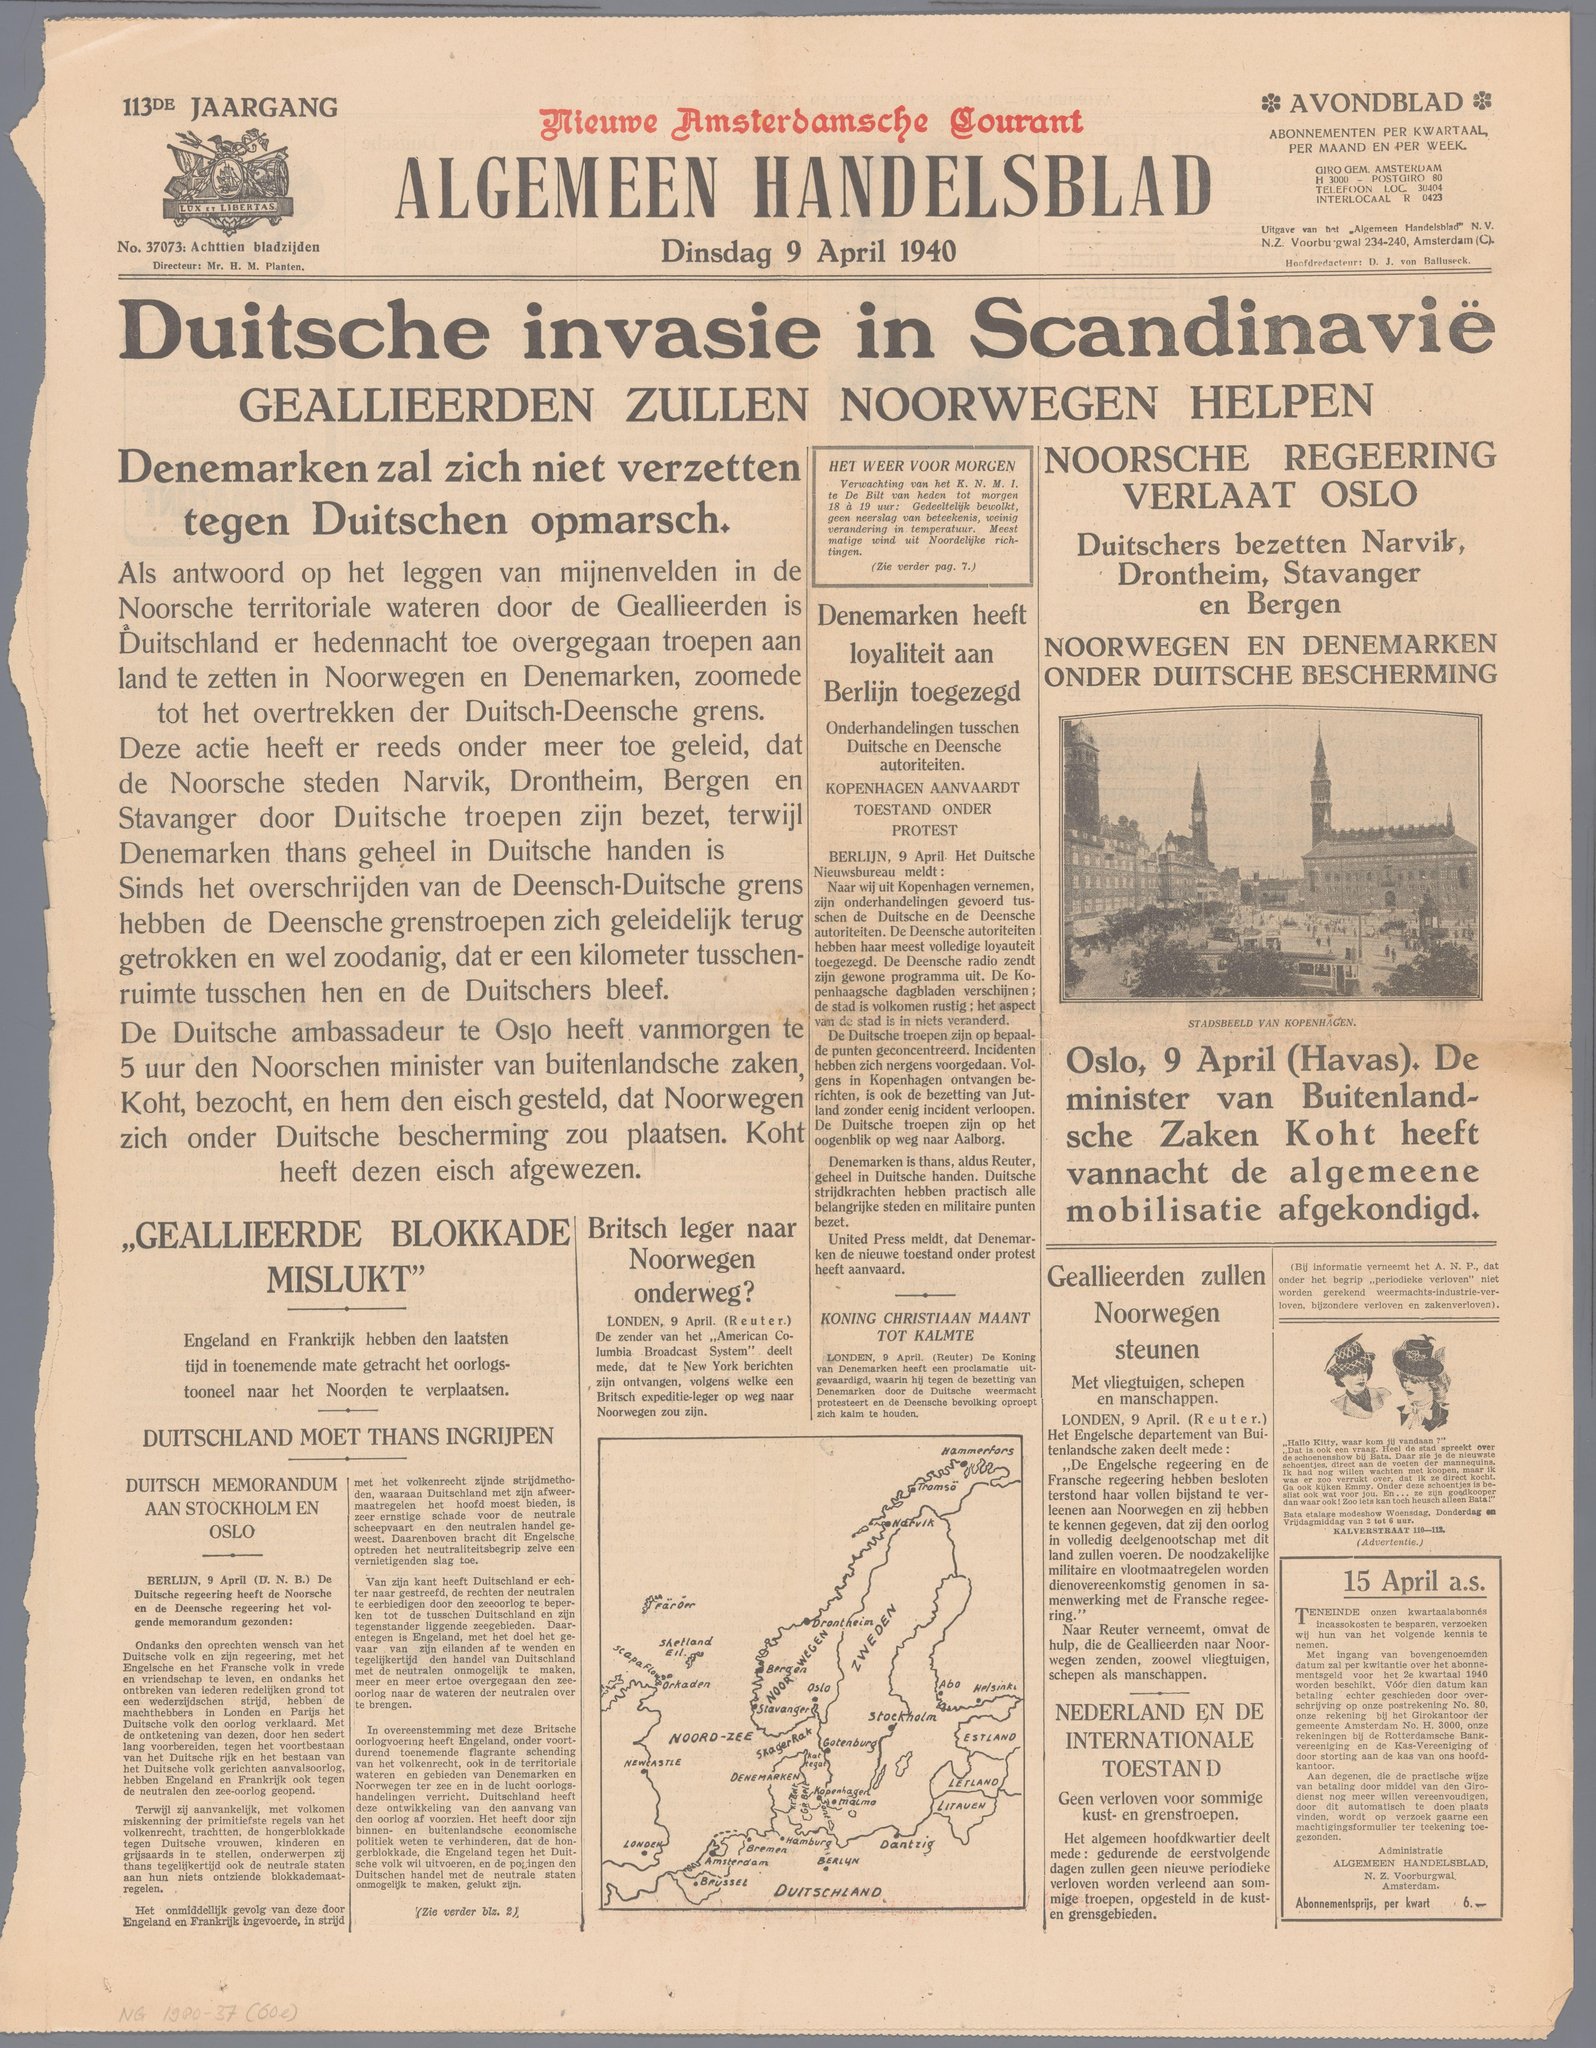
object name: newspaper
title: Algemeen Handelsblad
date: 1940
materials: paper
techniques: printing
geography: amsterdam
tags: scandinavië, tweede wereldoorlog, duitse invasie in scandinavië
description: Krant over de duitse invasie in Scandinavië, 4 pp. (van 18) van nr. 37073 van de 113e jaargang van de Algemeen Handelsblad.